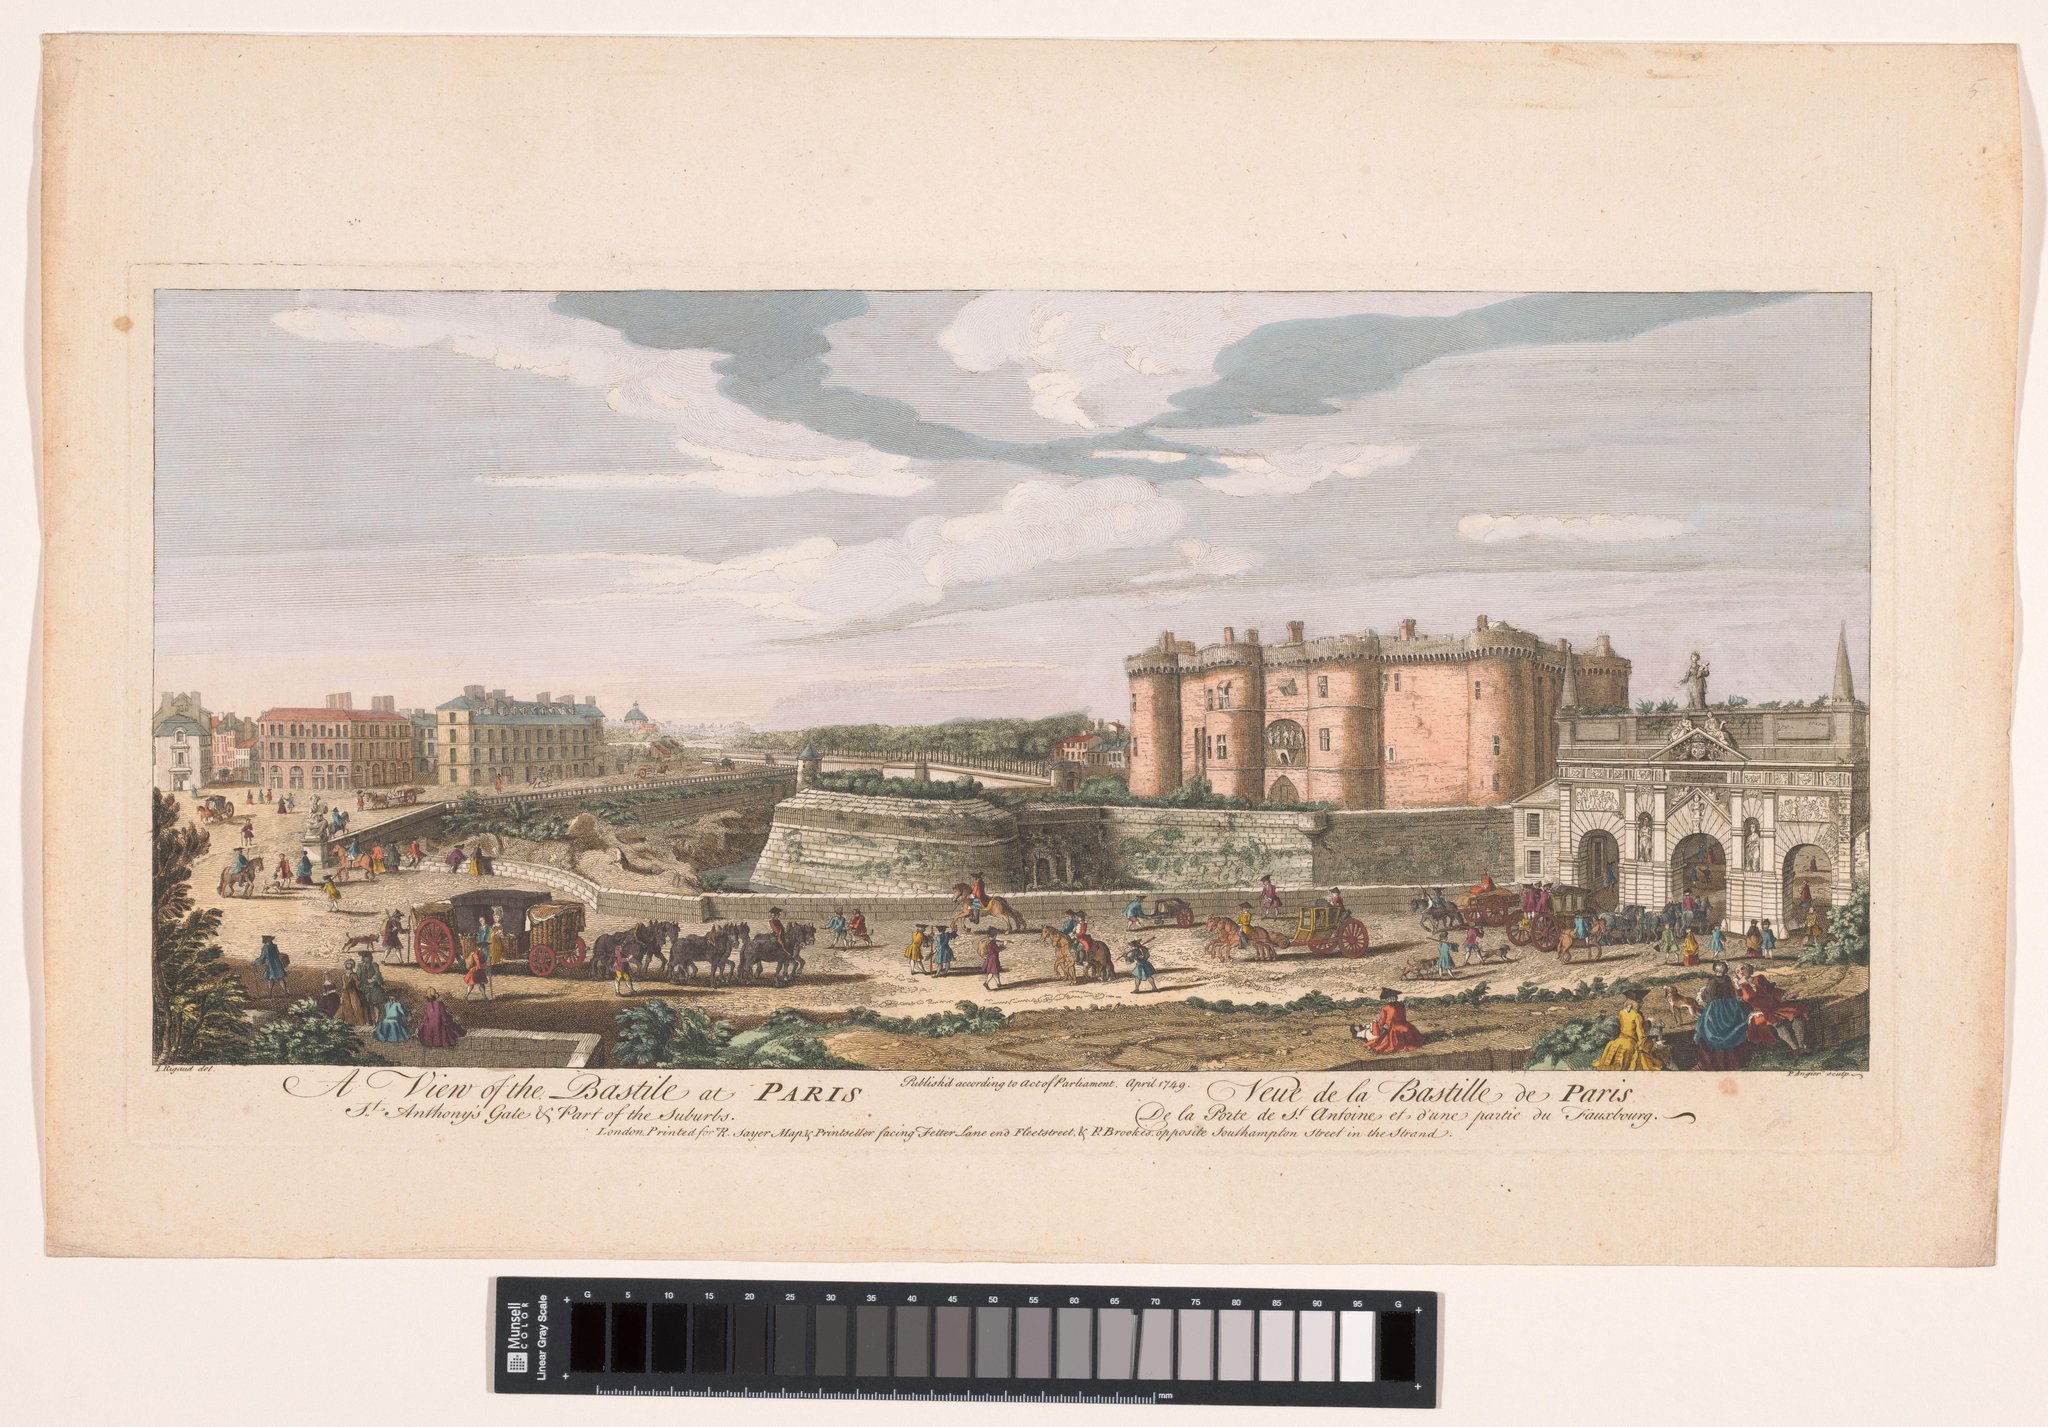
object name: print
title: Gezicht op de Bastille en de Porte Saint-Antoine te Parijs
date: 1704-1749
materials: paper, watercolor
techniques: brush, etching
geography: london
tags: fortress, gate, entrance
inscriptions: date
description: De serie “Parijs” bevat zes prenten met de nummers 1-6, waarvan dit nummer 5 is.